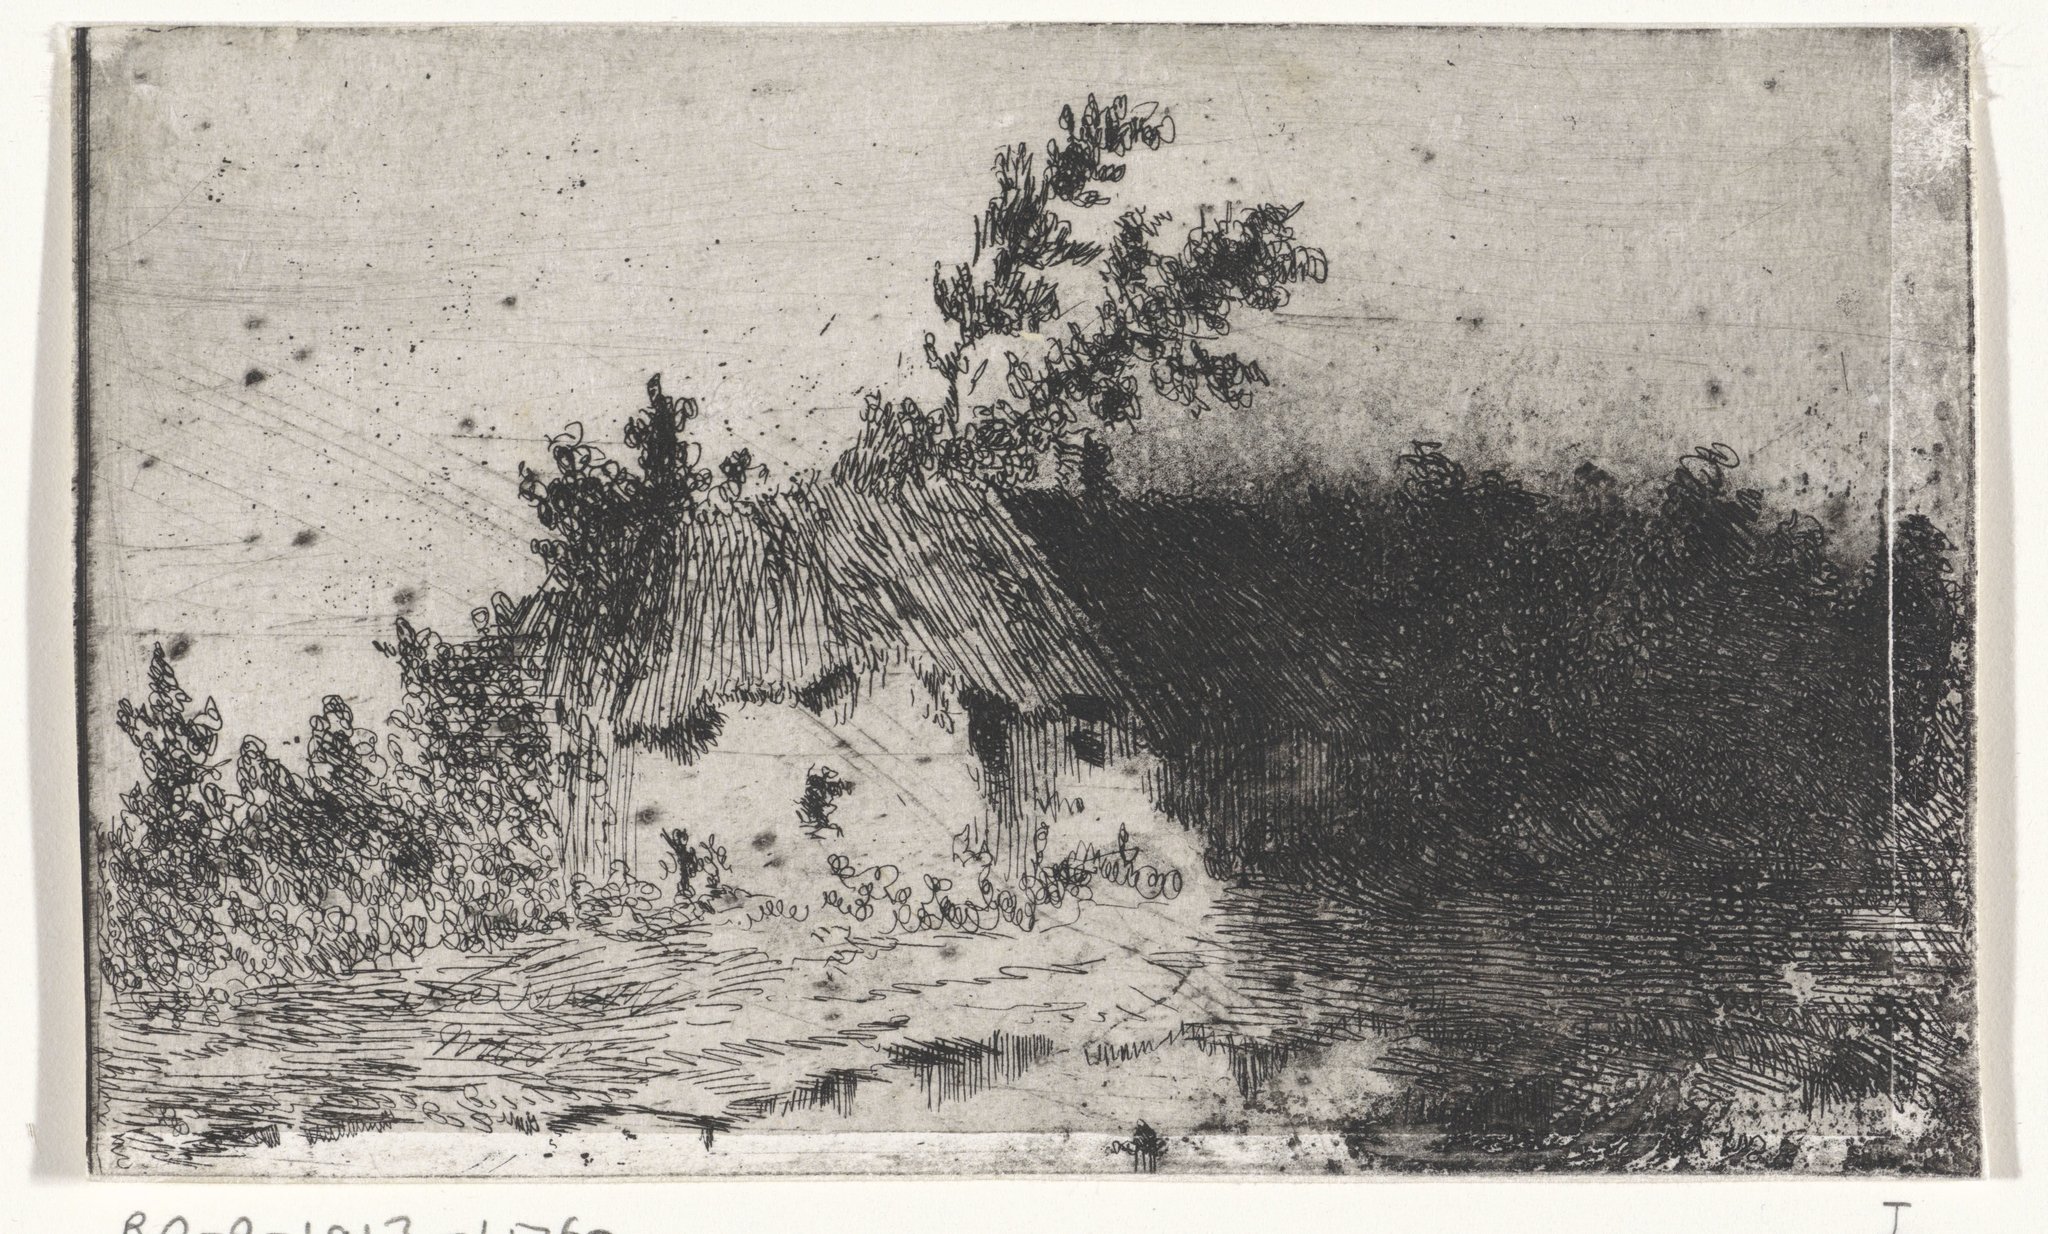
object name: print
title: Hut met rieten dak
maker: arnoud schaepkens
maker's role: print maker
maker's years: 1816-1904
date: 1831-1904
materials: paper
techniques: drypoint, etching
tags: cottage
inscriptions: collector's mark: Lugt 2228